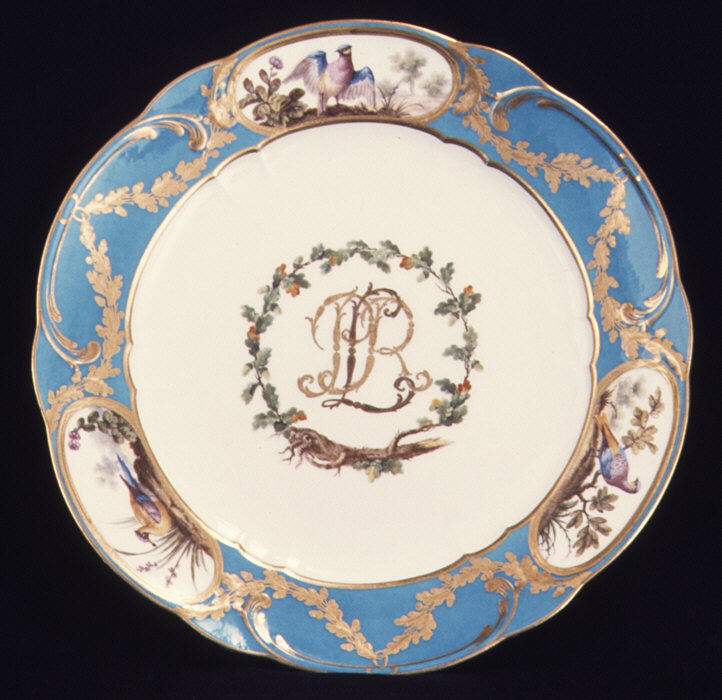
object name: plate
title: Plate (assiette à palmes) (one of four) (part of a service)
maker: sèvres manufactory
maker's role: manufactory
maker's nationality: french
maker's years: 1740-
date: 1771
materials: soft paste porcelain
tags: birds,flowers,insignia